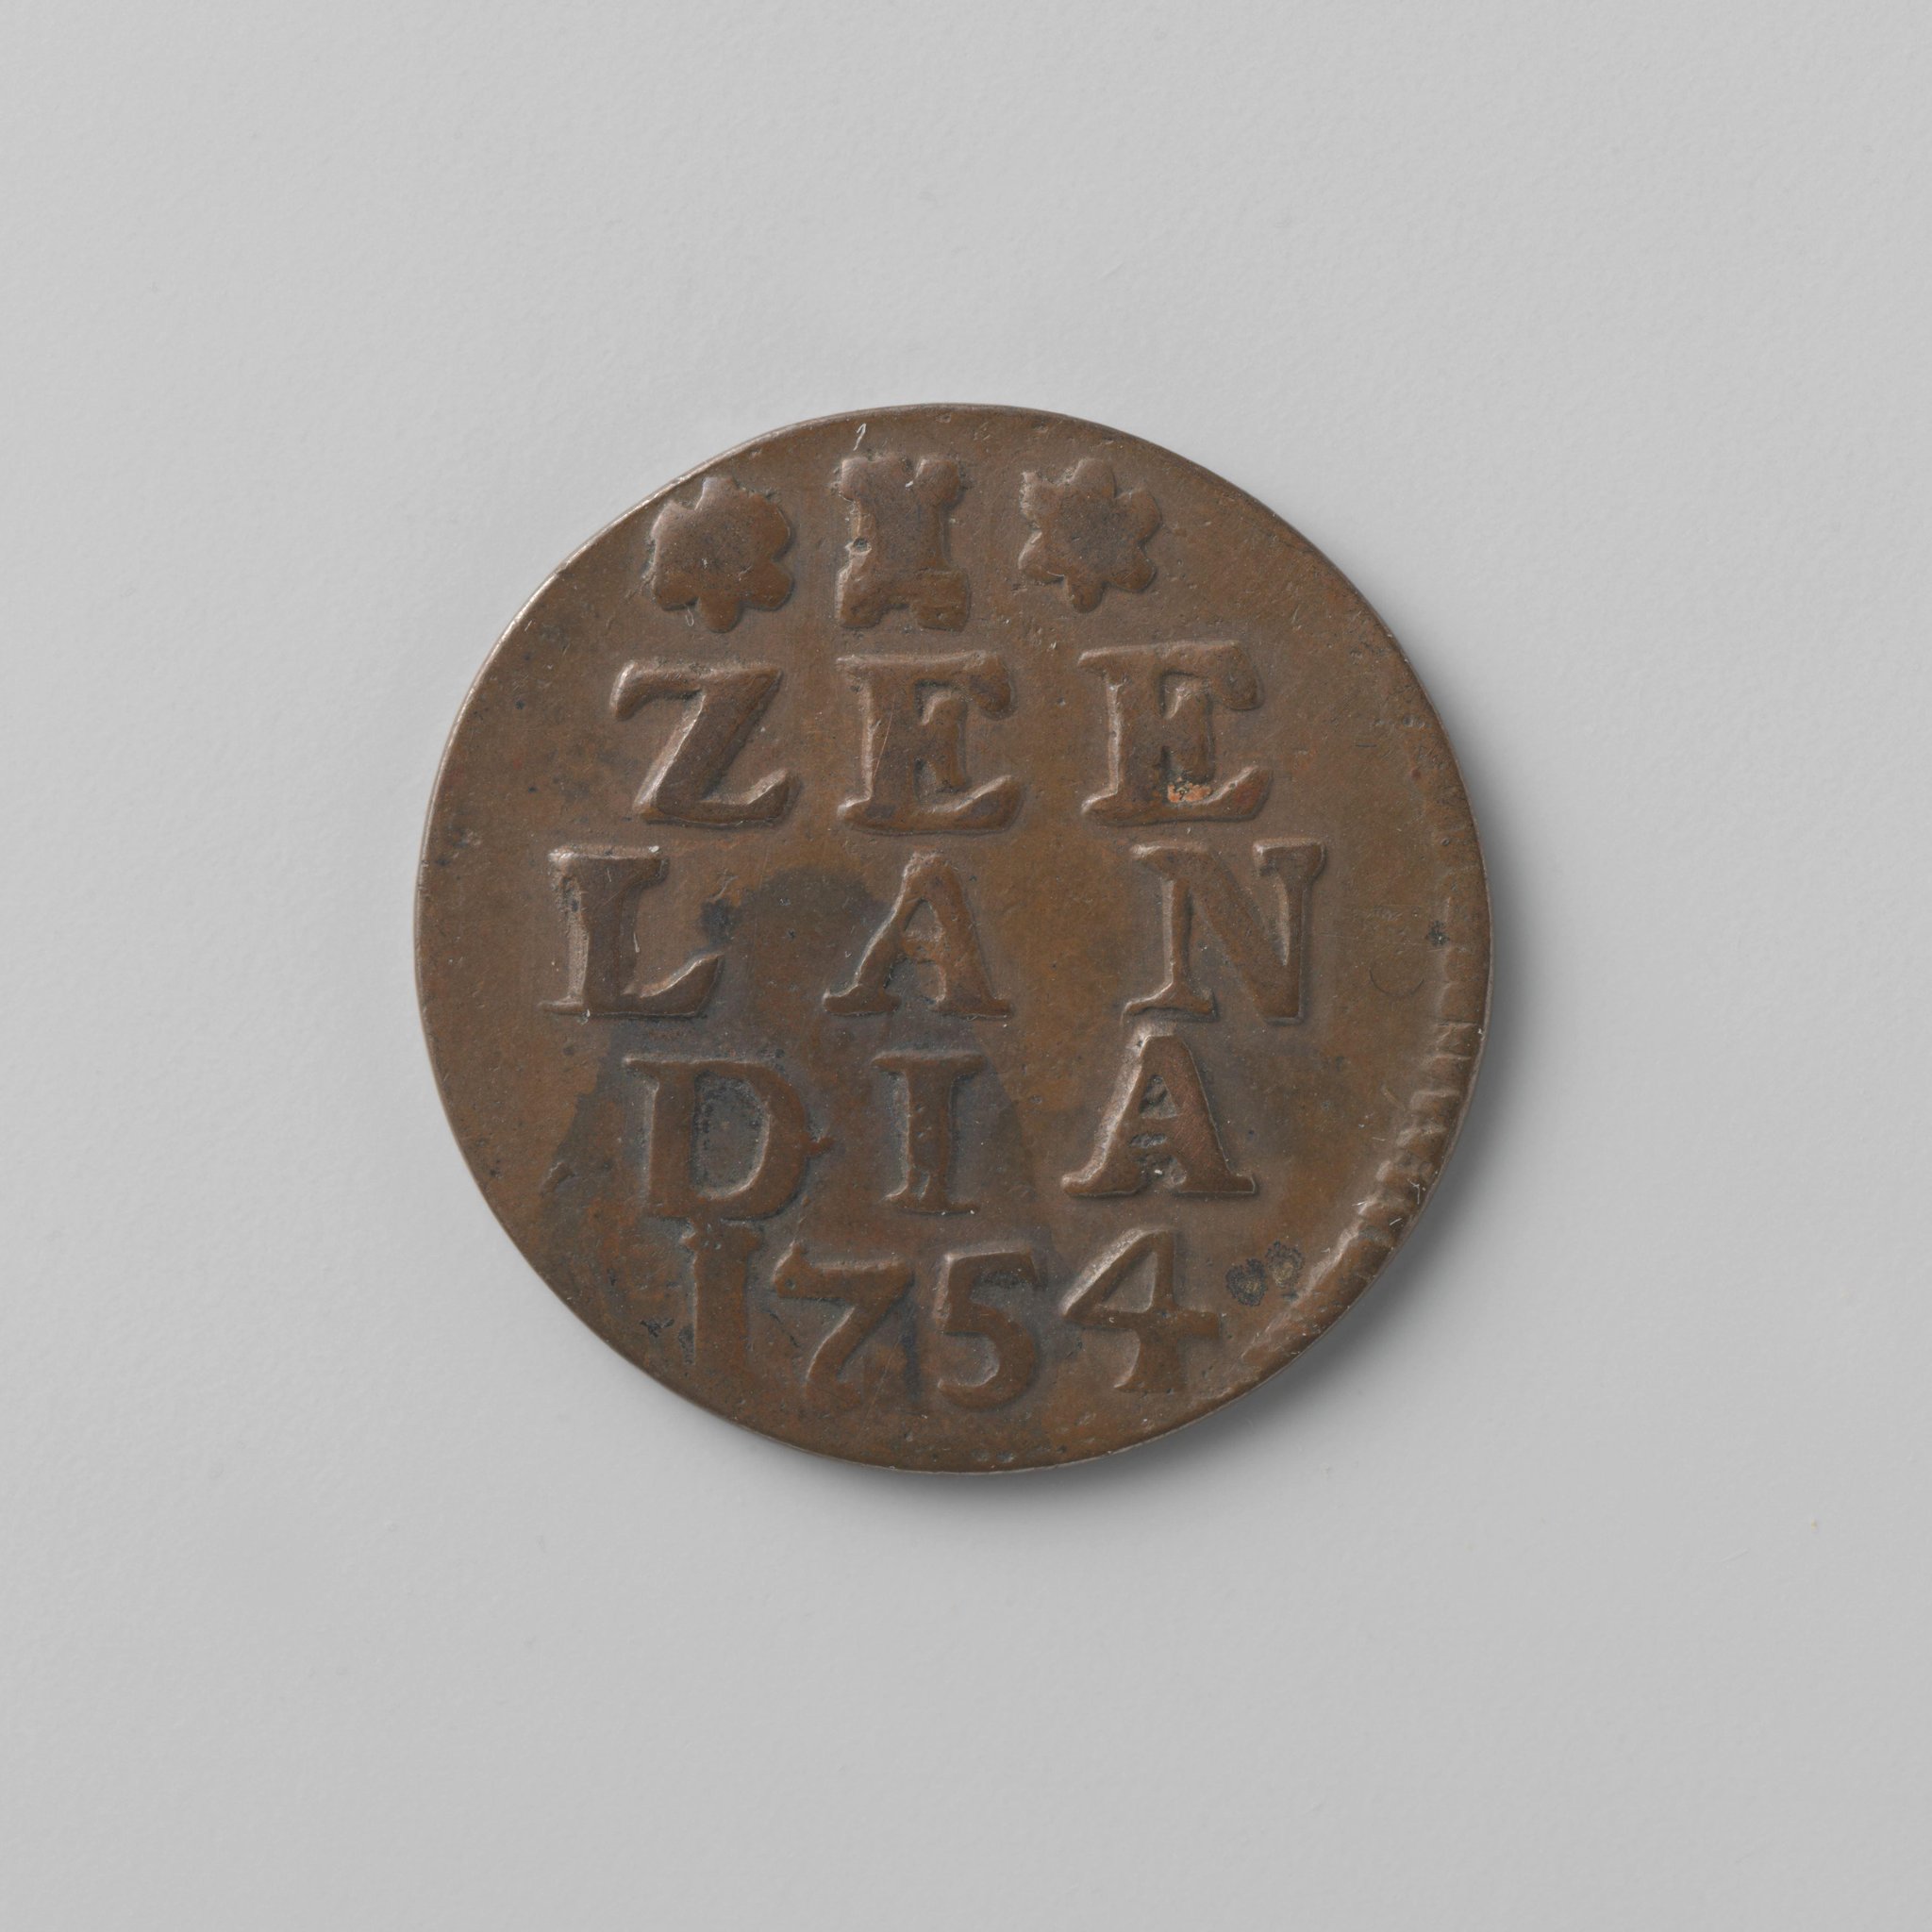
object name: coin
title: Zeeuwse duit, 1754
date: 1754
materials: copper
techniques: striking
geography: middelburg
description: Koperen munt. Voorzijde: gekroond, zijdelings ingedeukt wapenschild van Zeeland, omschrift eindigend in EMENTOR. Keerzijde: opschrift in drie regels, waarboven muntteken burcht tussen twee sterren en waaronder jaartal.